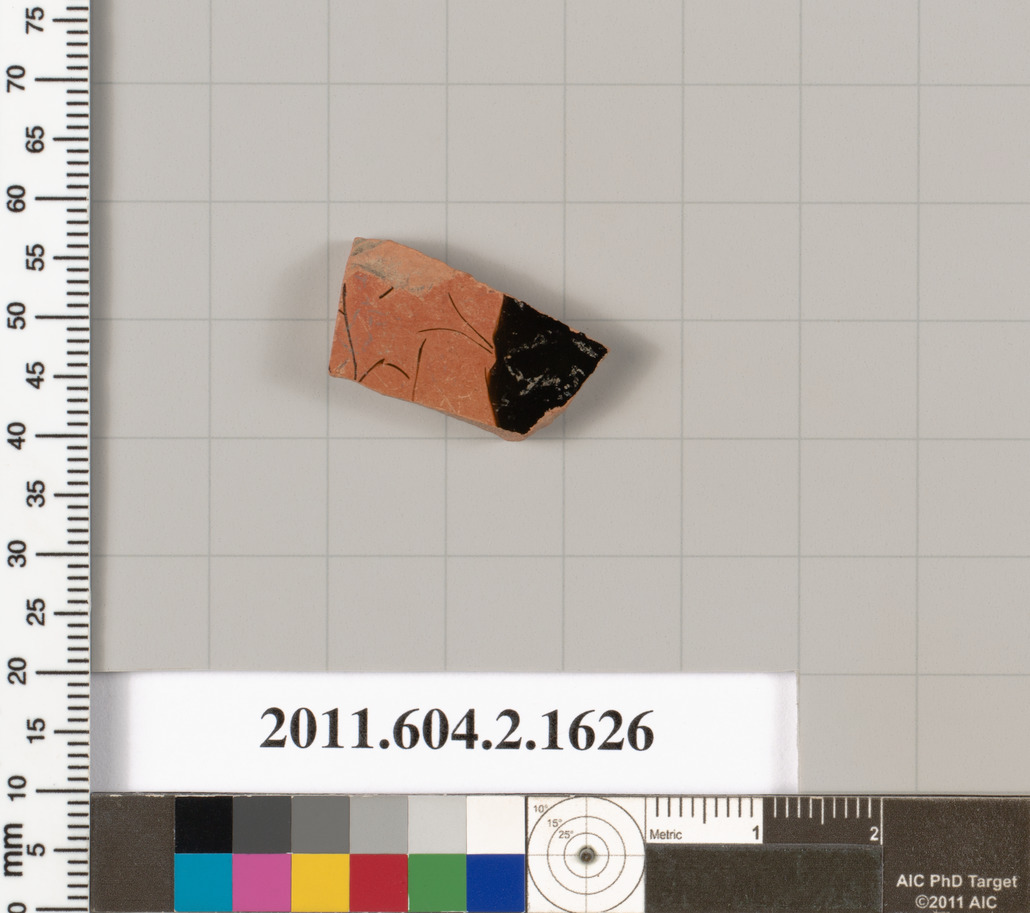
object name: skyphos fragment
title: Terracotta fragment of a skyphos (deep drinking cup)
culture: greek, attic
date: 460-450 BCE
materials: terracotta